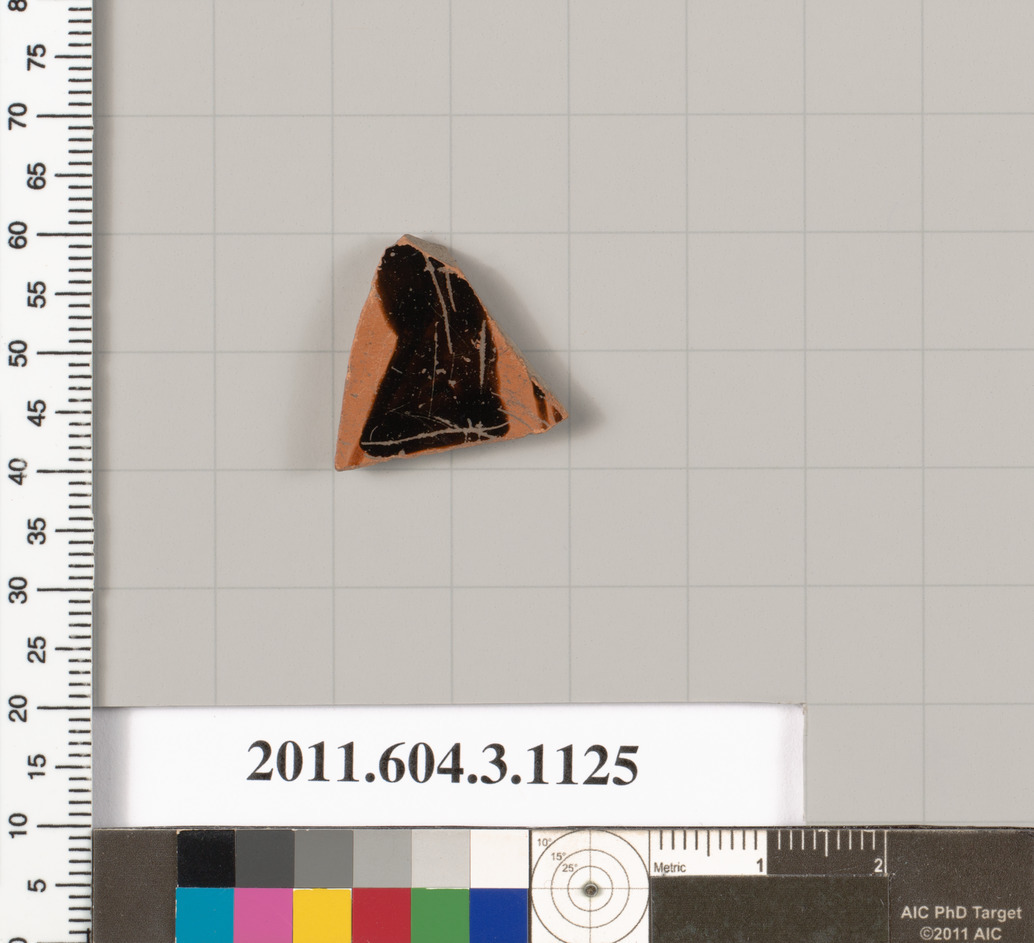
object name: mastoid or kyathos fragment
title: Terracotta fragment of a mastoid (drinking cup with narrow base) or a kyathos (cup-shaped ladle)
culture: greek, attic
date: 534-468 BCE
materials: terracotta